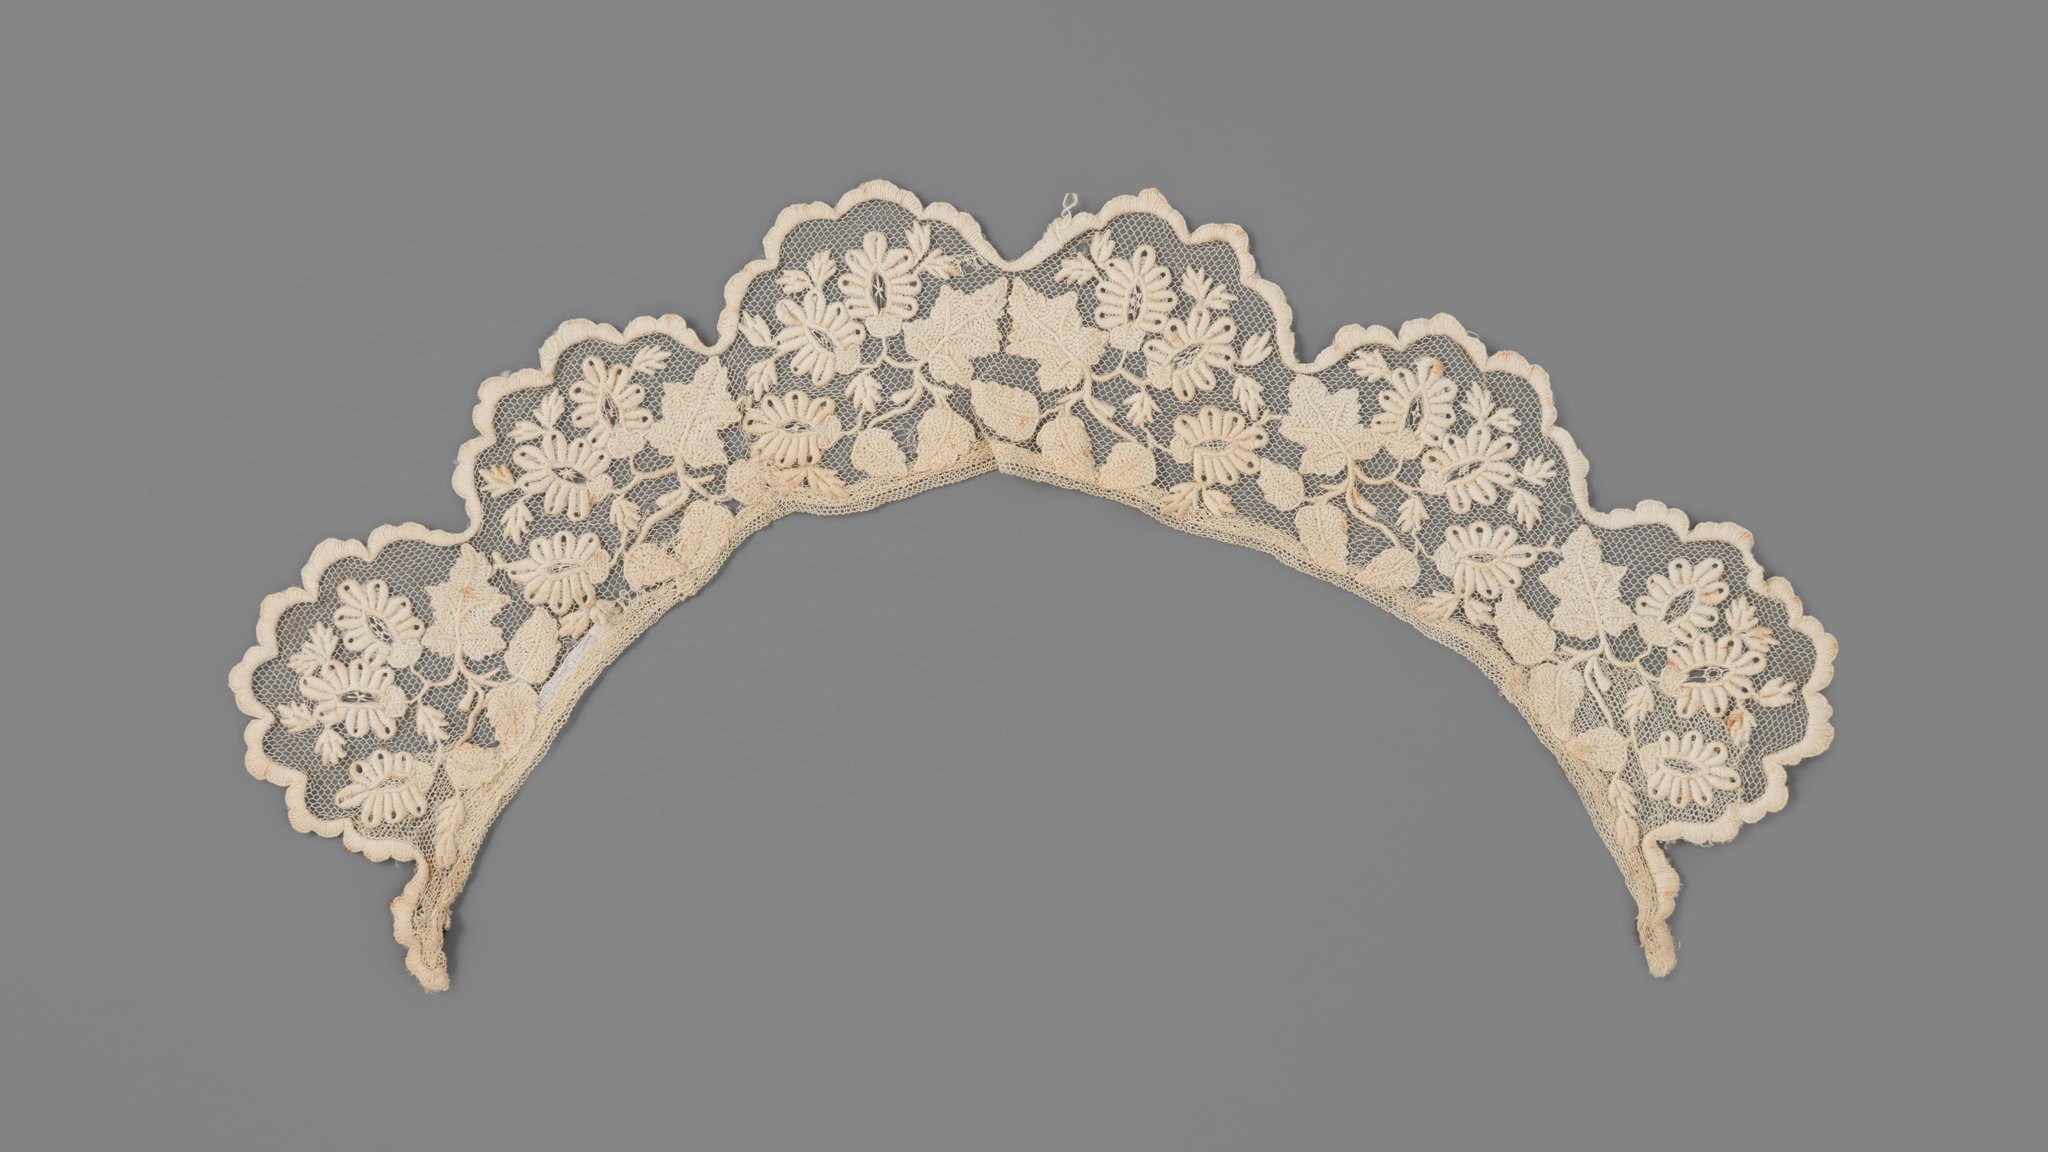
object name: sjaalkraag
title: Sjaalkraag van geborduurde tule, wit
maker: Anonymous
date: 1860-1880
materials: metal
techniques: embroidered, embroidery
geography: western europe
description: Sjaalkraag van geborduurde tule, wit. De kraag is vlak, rond en heeft een schulpenrand die is onderverdeeld in kleinere schulpen. Het borduursel bestaat uit bloem- en bladmotieven.